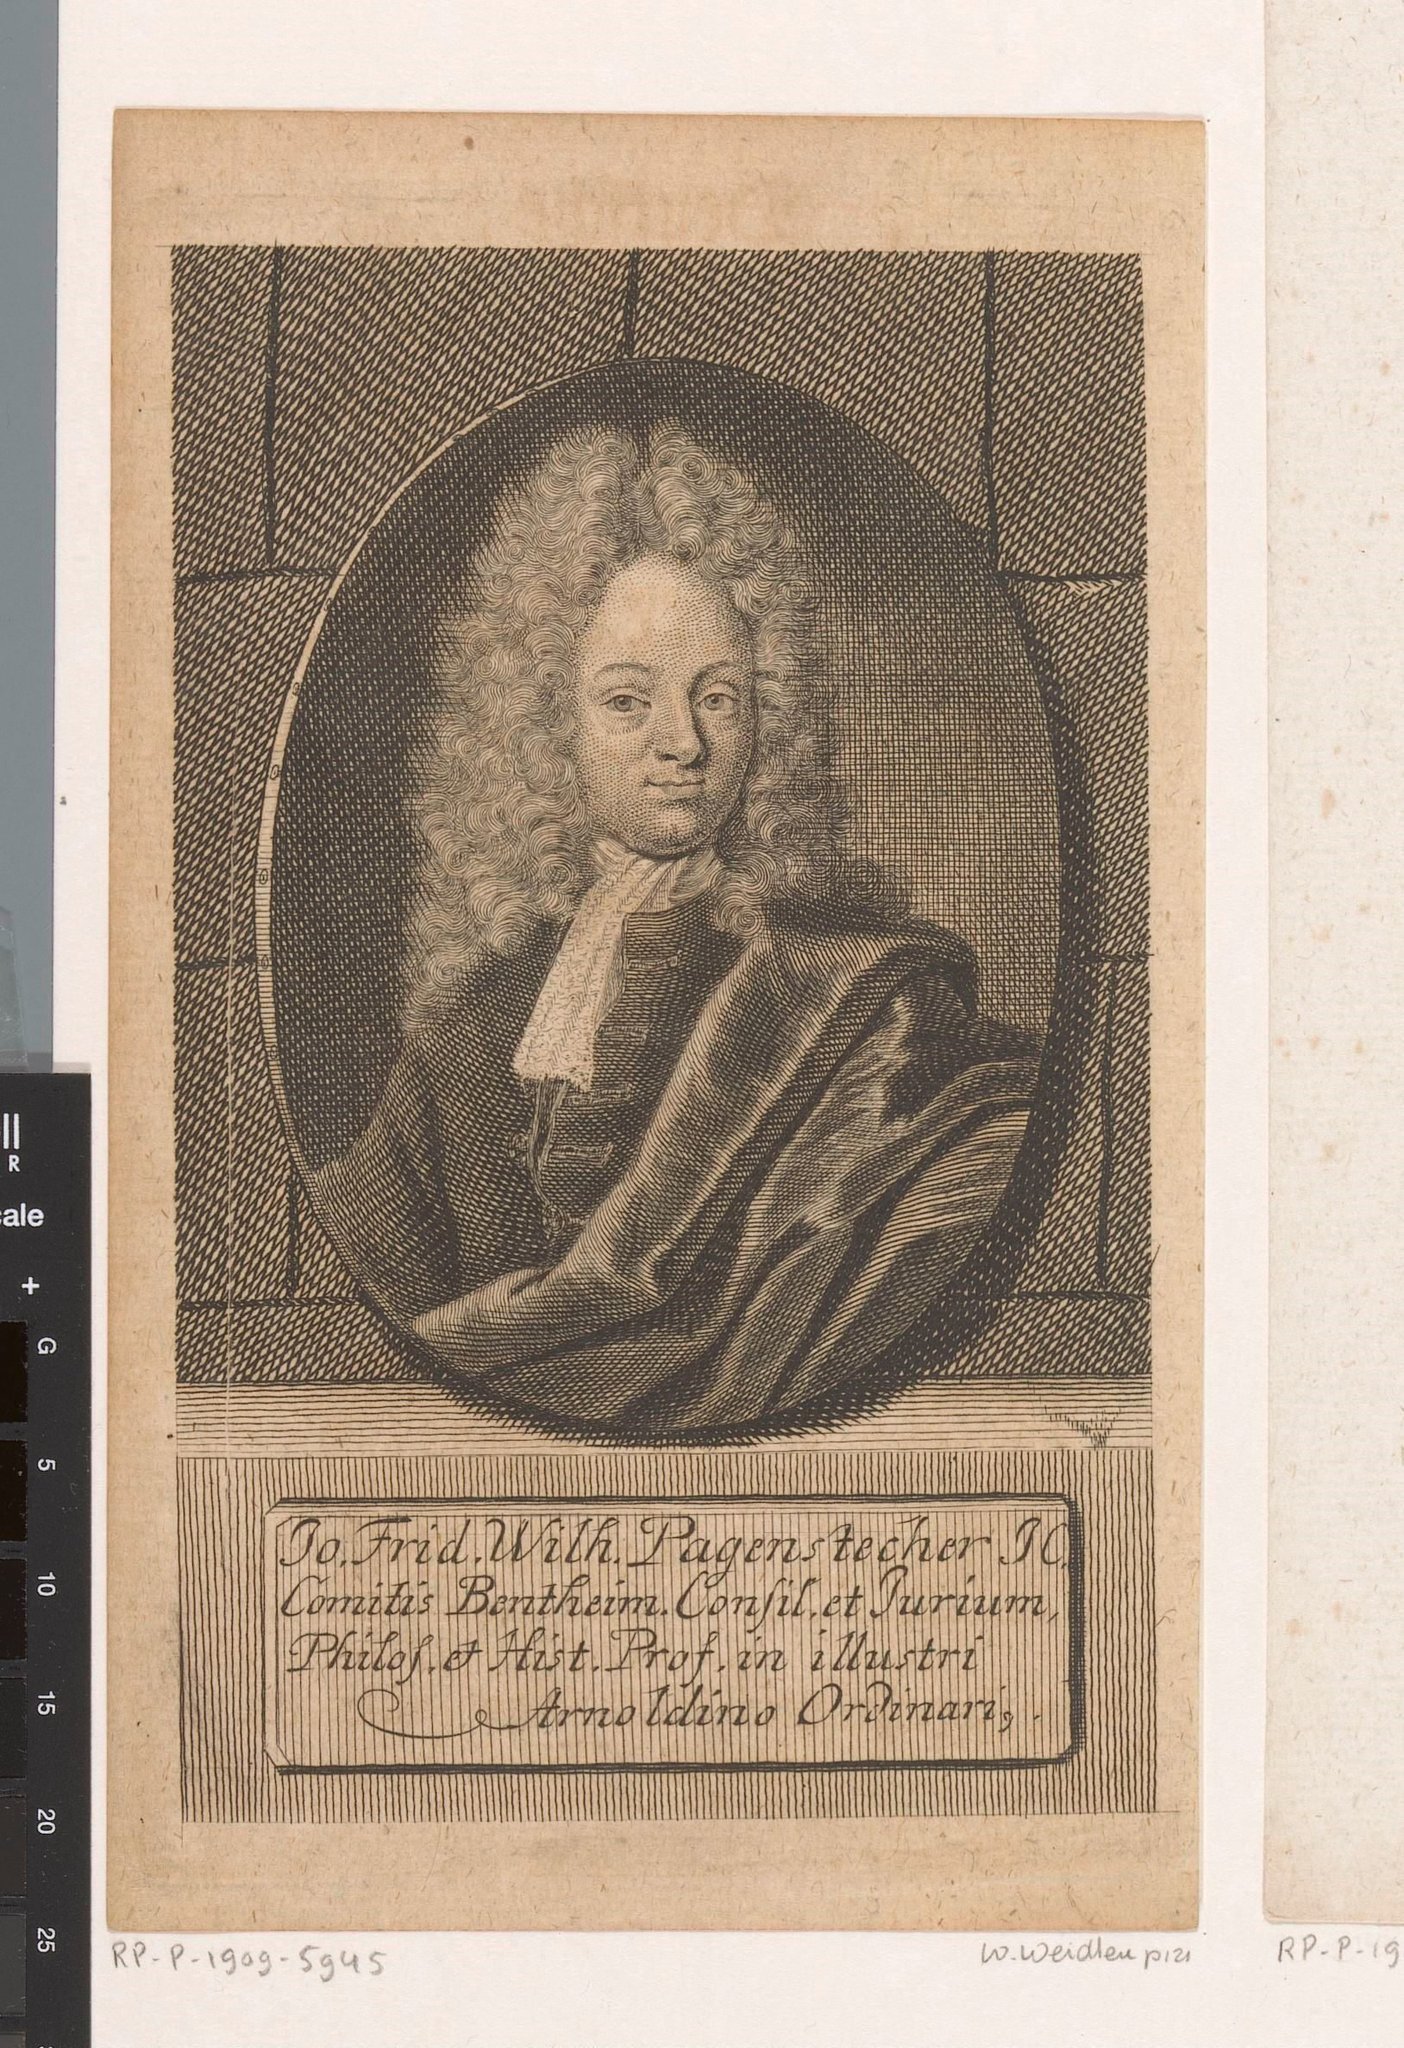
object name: print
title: Portret van Johann Friedrich Wilhelm Pagenstecher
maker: martin bernigeroth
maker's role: print maker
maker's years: 1670-1733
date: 1716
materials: paper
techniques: engraving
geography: leipzig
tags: historical persons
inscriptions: collector's mark: Lugt 2228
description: Prent ook gebruikt in: Deutsche Acta Eruditorum (...). dl. 44. Leipzig: Johann Gottlieb Gleditsch, 1716.